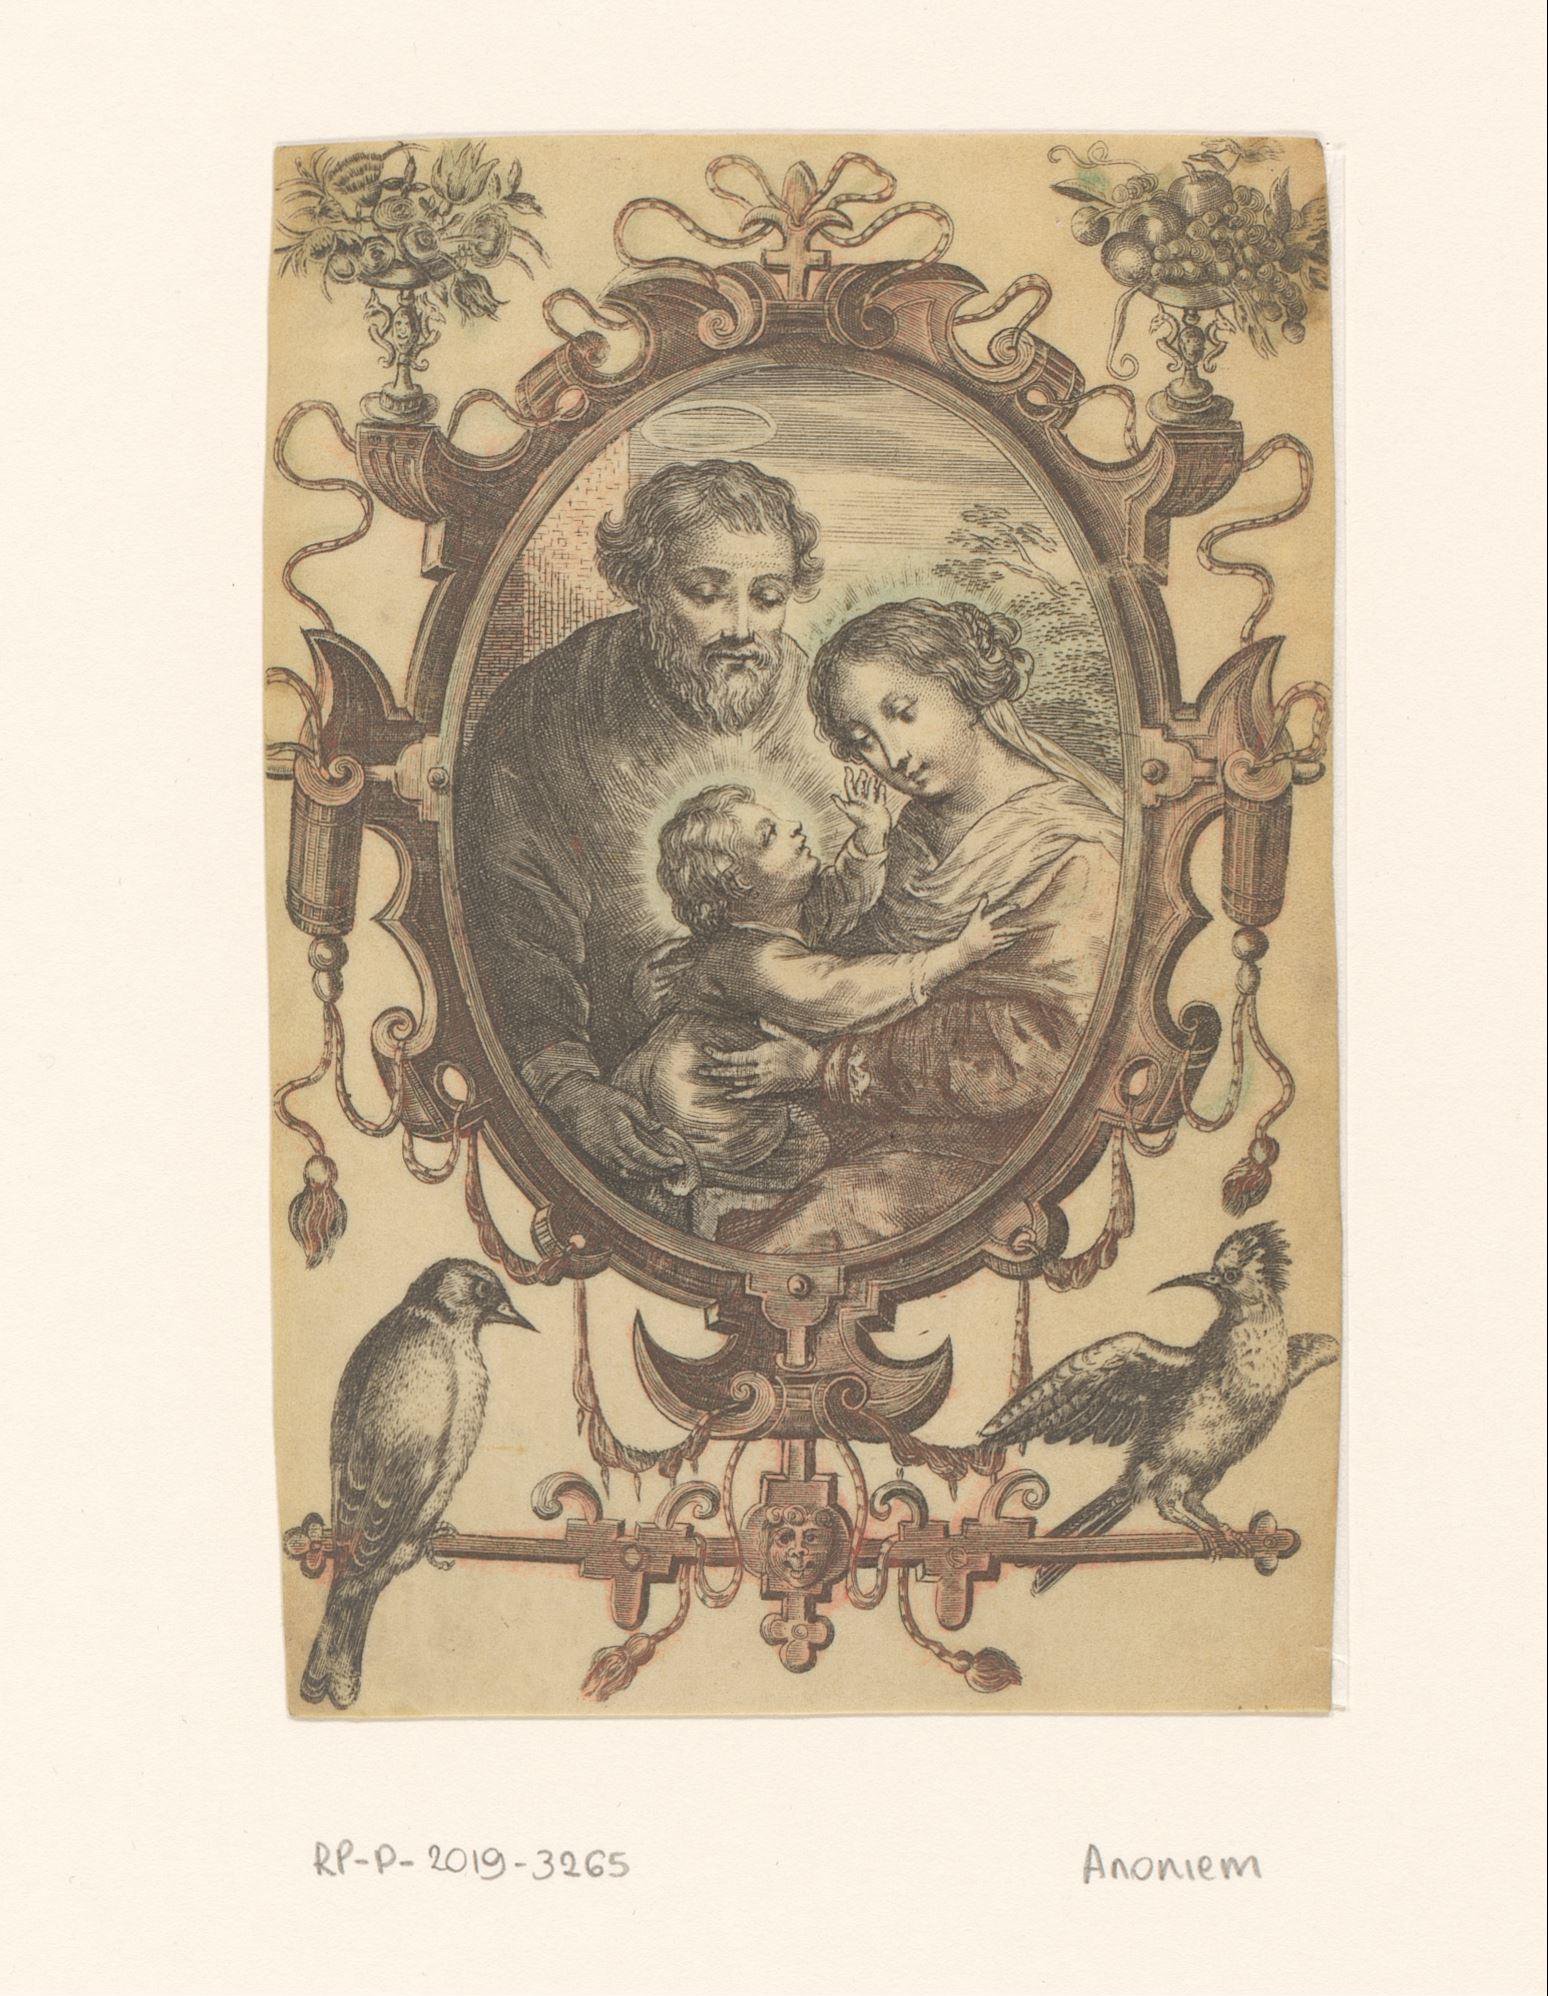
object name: print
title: Heilige familie in een ornamentele cartouche met twee vogels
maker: Anonymous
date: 1600-1699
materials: parchment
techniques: engraving, hand coloring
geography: netherlands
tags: other birds: hoopoe, other birds: woodpecker, holy family (alone), 'trinitas terrestris', ornament ~ cartouche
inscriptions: collector's mark: Lugt 2228